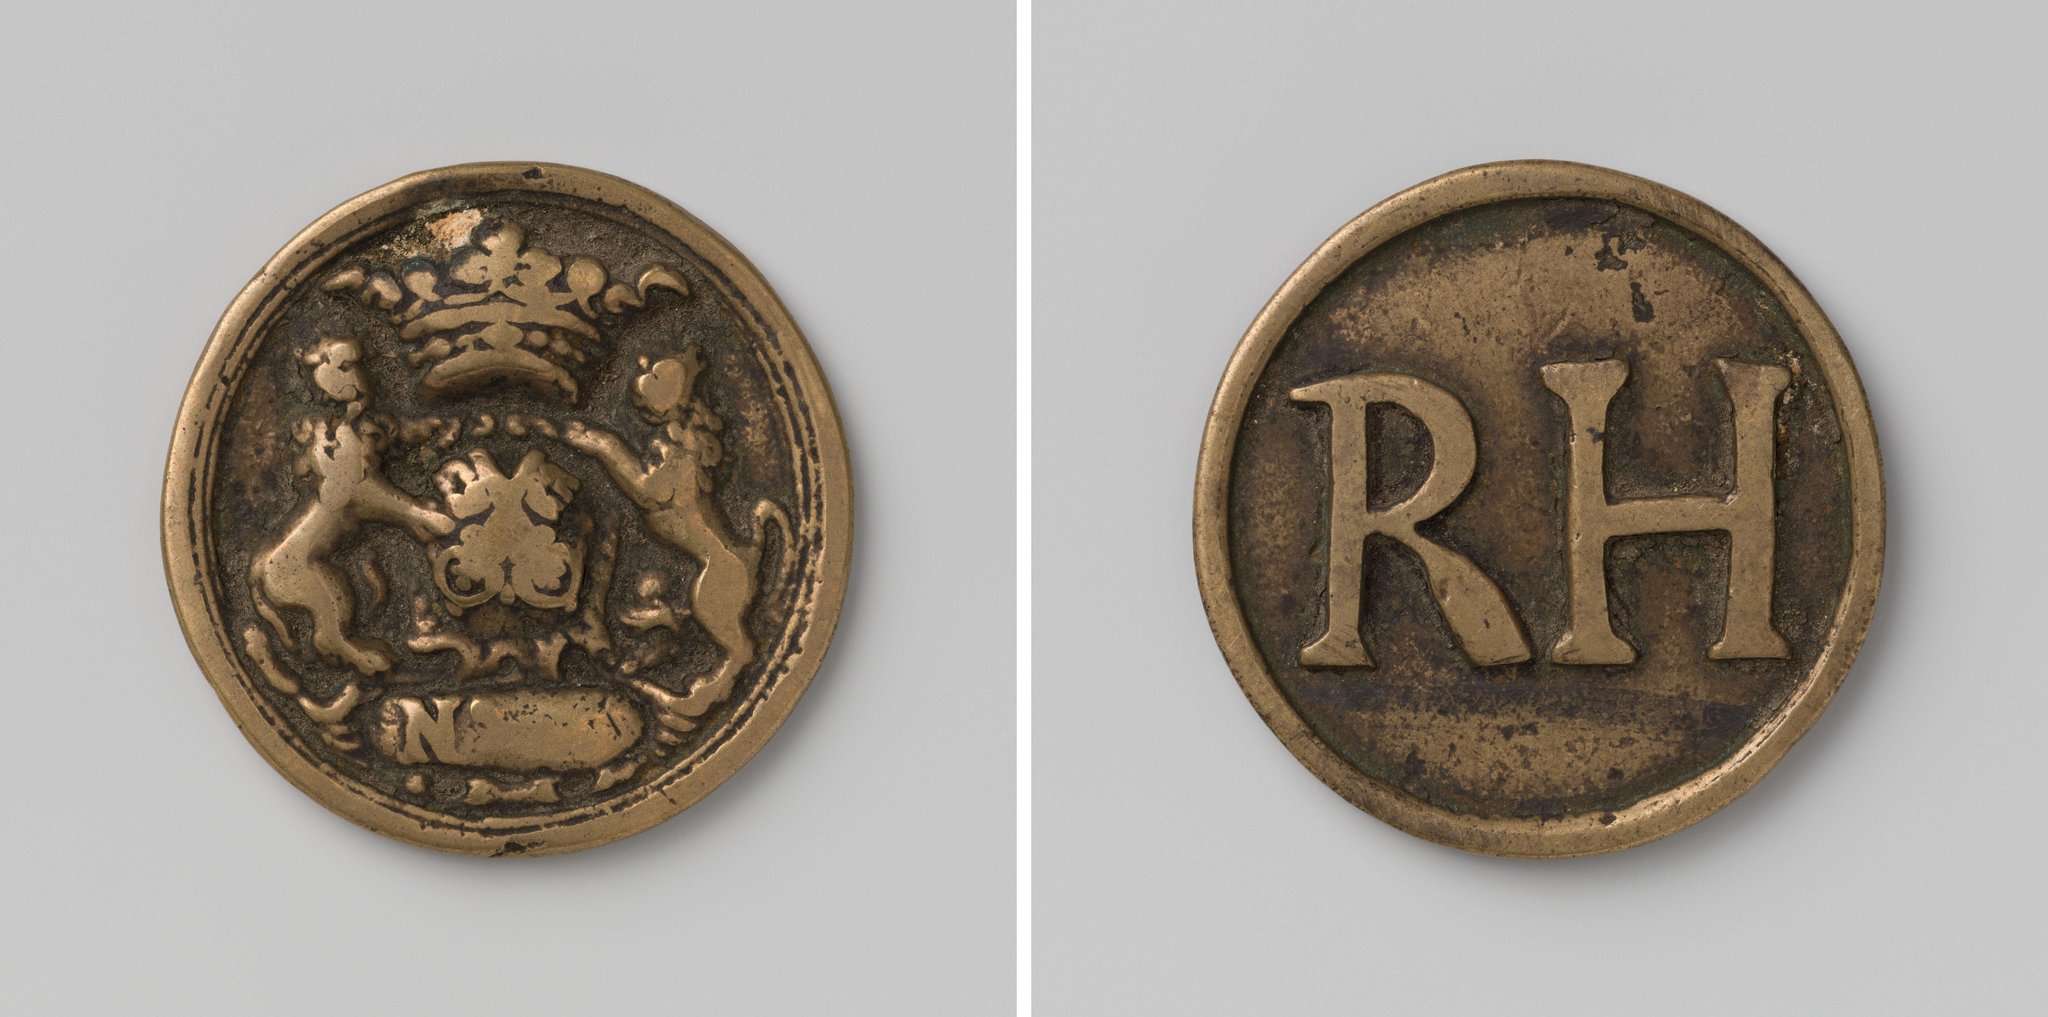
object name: medal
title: Leiden, brandspuitpenning met monogram R.H.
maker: Anonymous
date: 1680-1800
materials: brass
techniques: casting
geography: leiden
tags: leiden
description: Messing penning. Voorzijde: gekroond wapenschild, geflankeerd door twee leeuwen boven compartiment met gedeeltelijk leesbaar opschrift beginnend met No.. Keerzijde: monogram van letters R en H